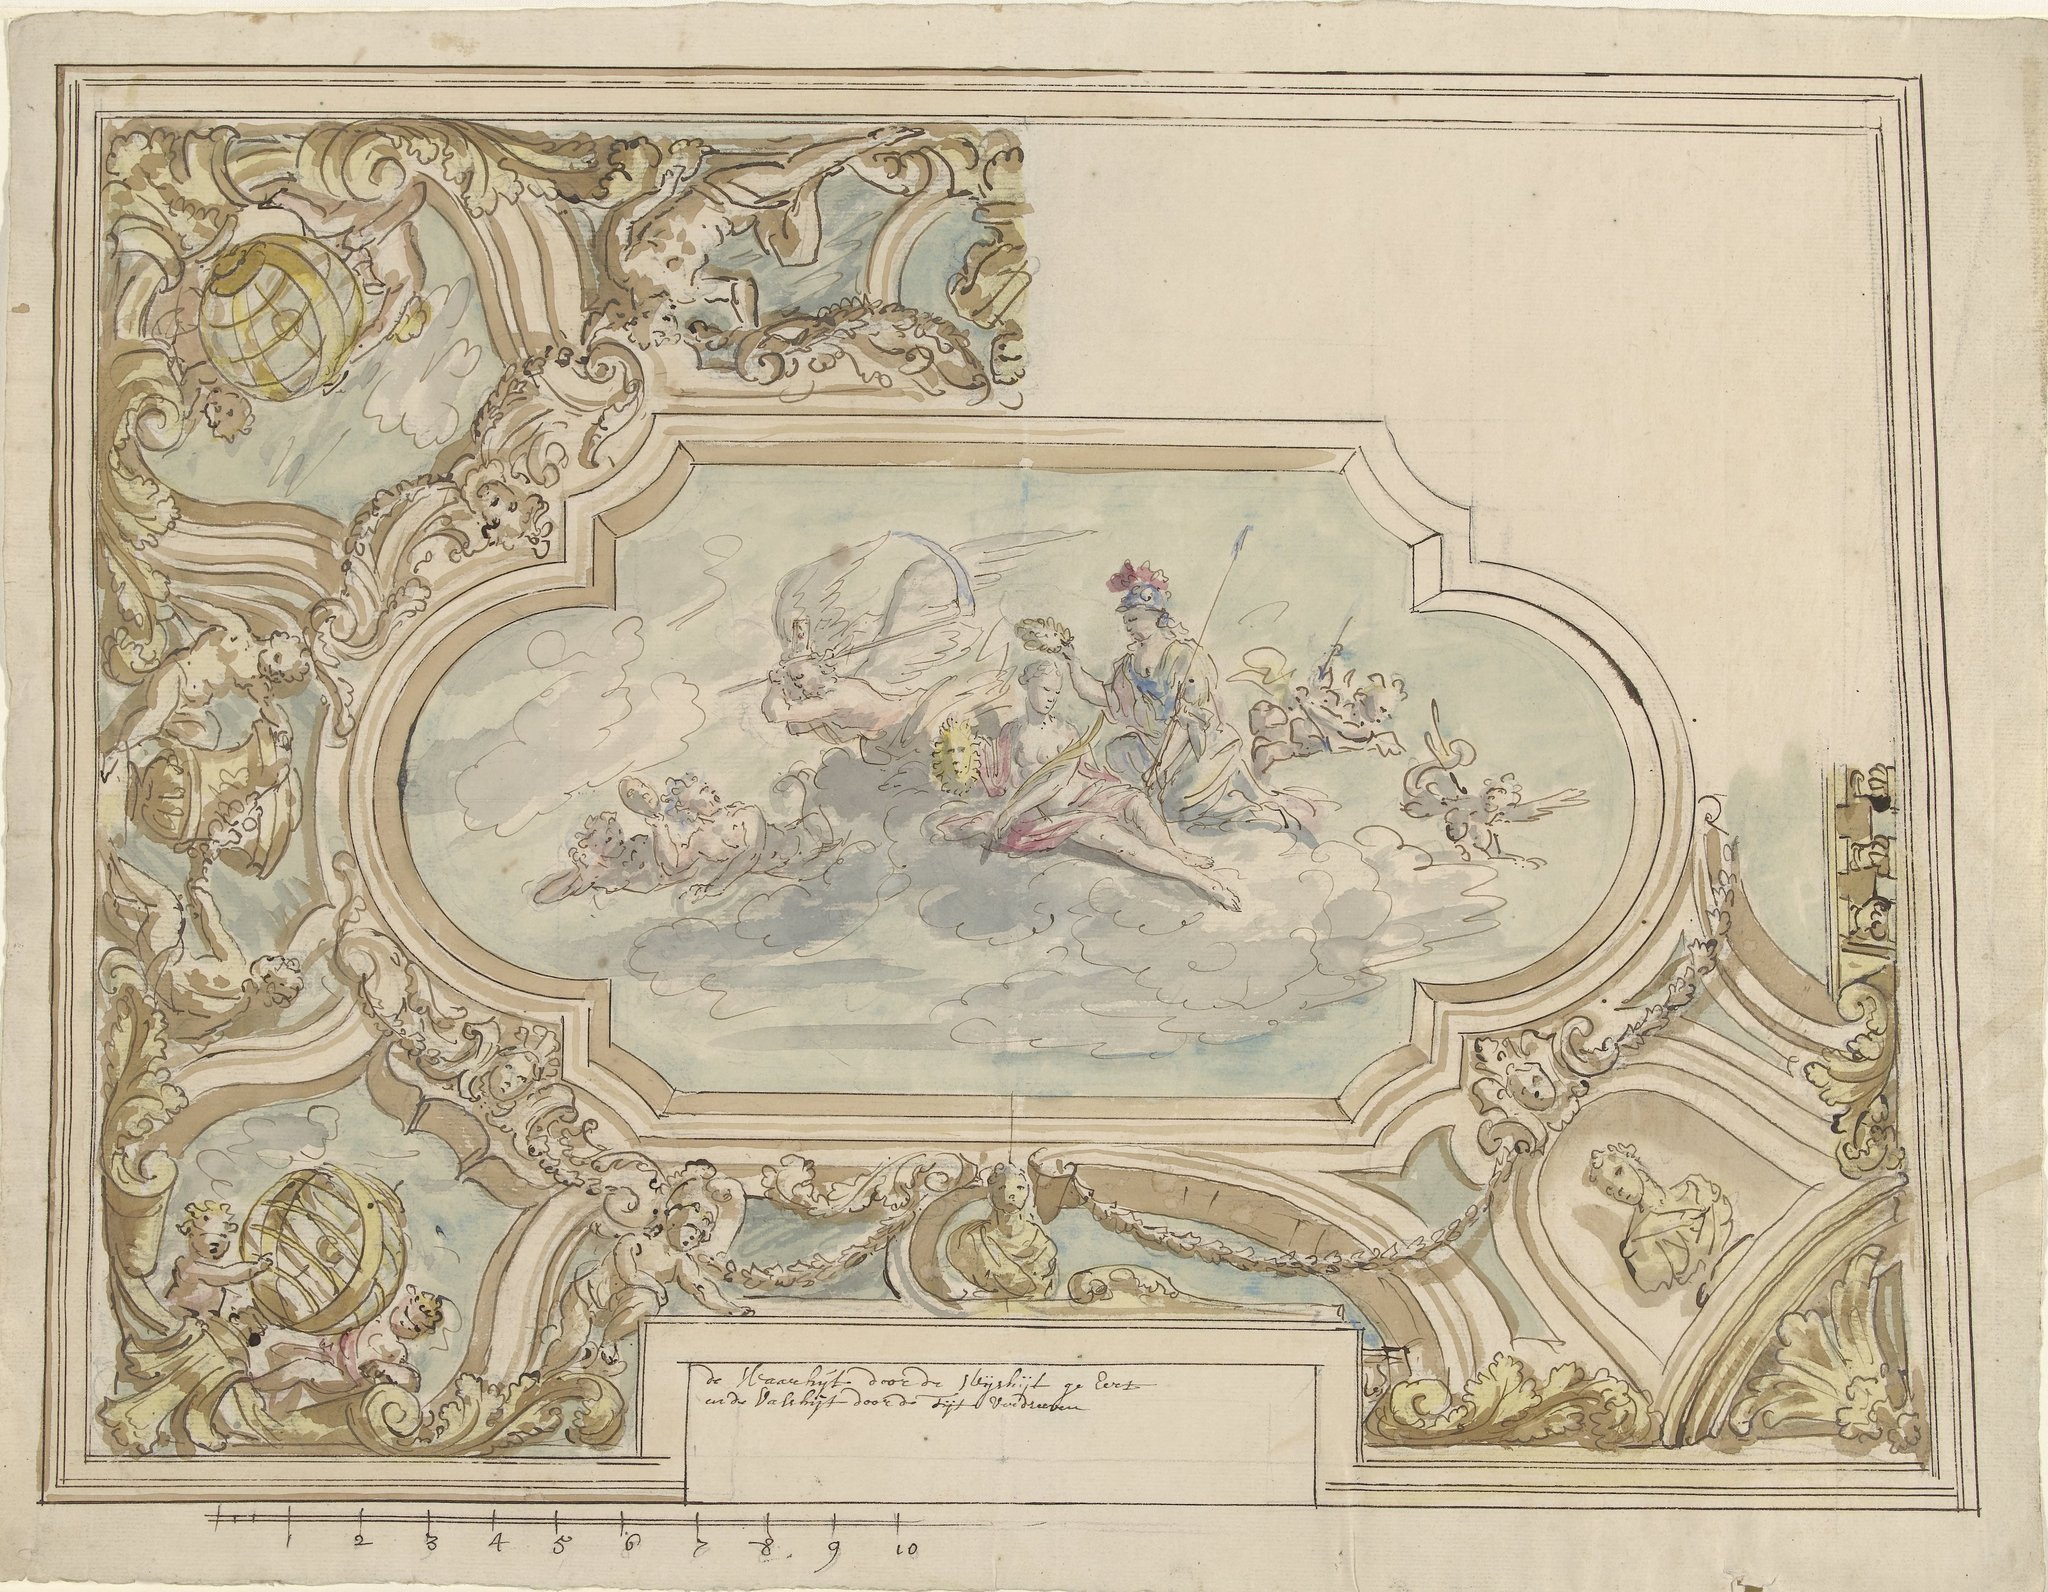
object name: watercolor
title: Ontwerp voor een plafondschildering met allegorie op de waarheid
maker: elias van nijmegen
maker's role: draughtsman, painter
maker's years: 1667-1755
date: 1677-1755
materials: ink, paper, pencil, watercolor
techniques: brush, pen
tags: allegorical representations of the effects of time, truth; 'verità' (ripa), (decorated) ceiling, honour, glory; 'ampiezza della gloria', 'gloria', 'gloria de prencipi', 'gloria & honore', 'honore', 'sublimatà della gloria' (ripa), falsehood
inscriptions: inscription: ‘De Waarhijt door de Wijshijt geEert en de Valshijt door de Tijt Verdreeven’